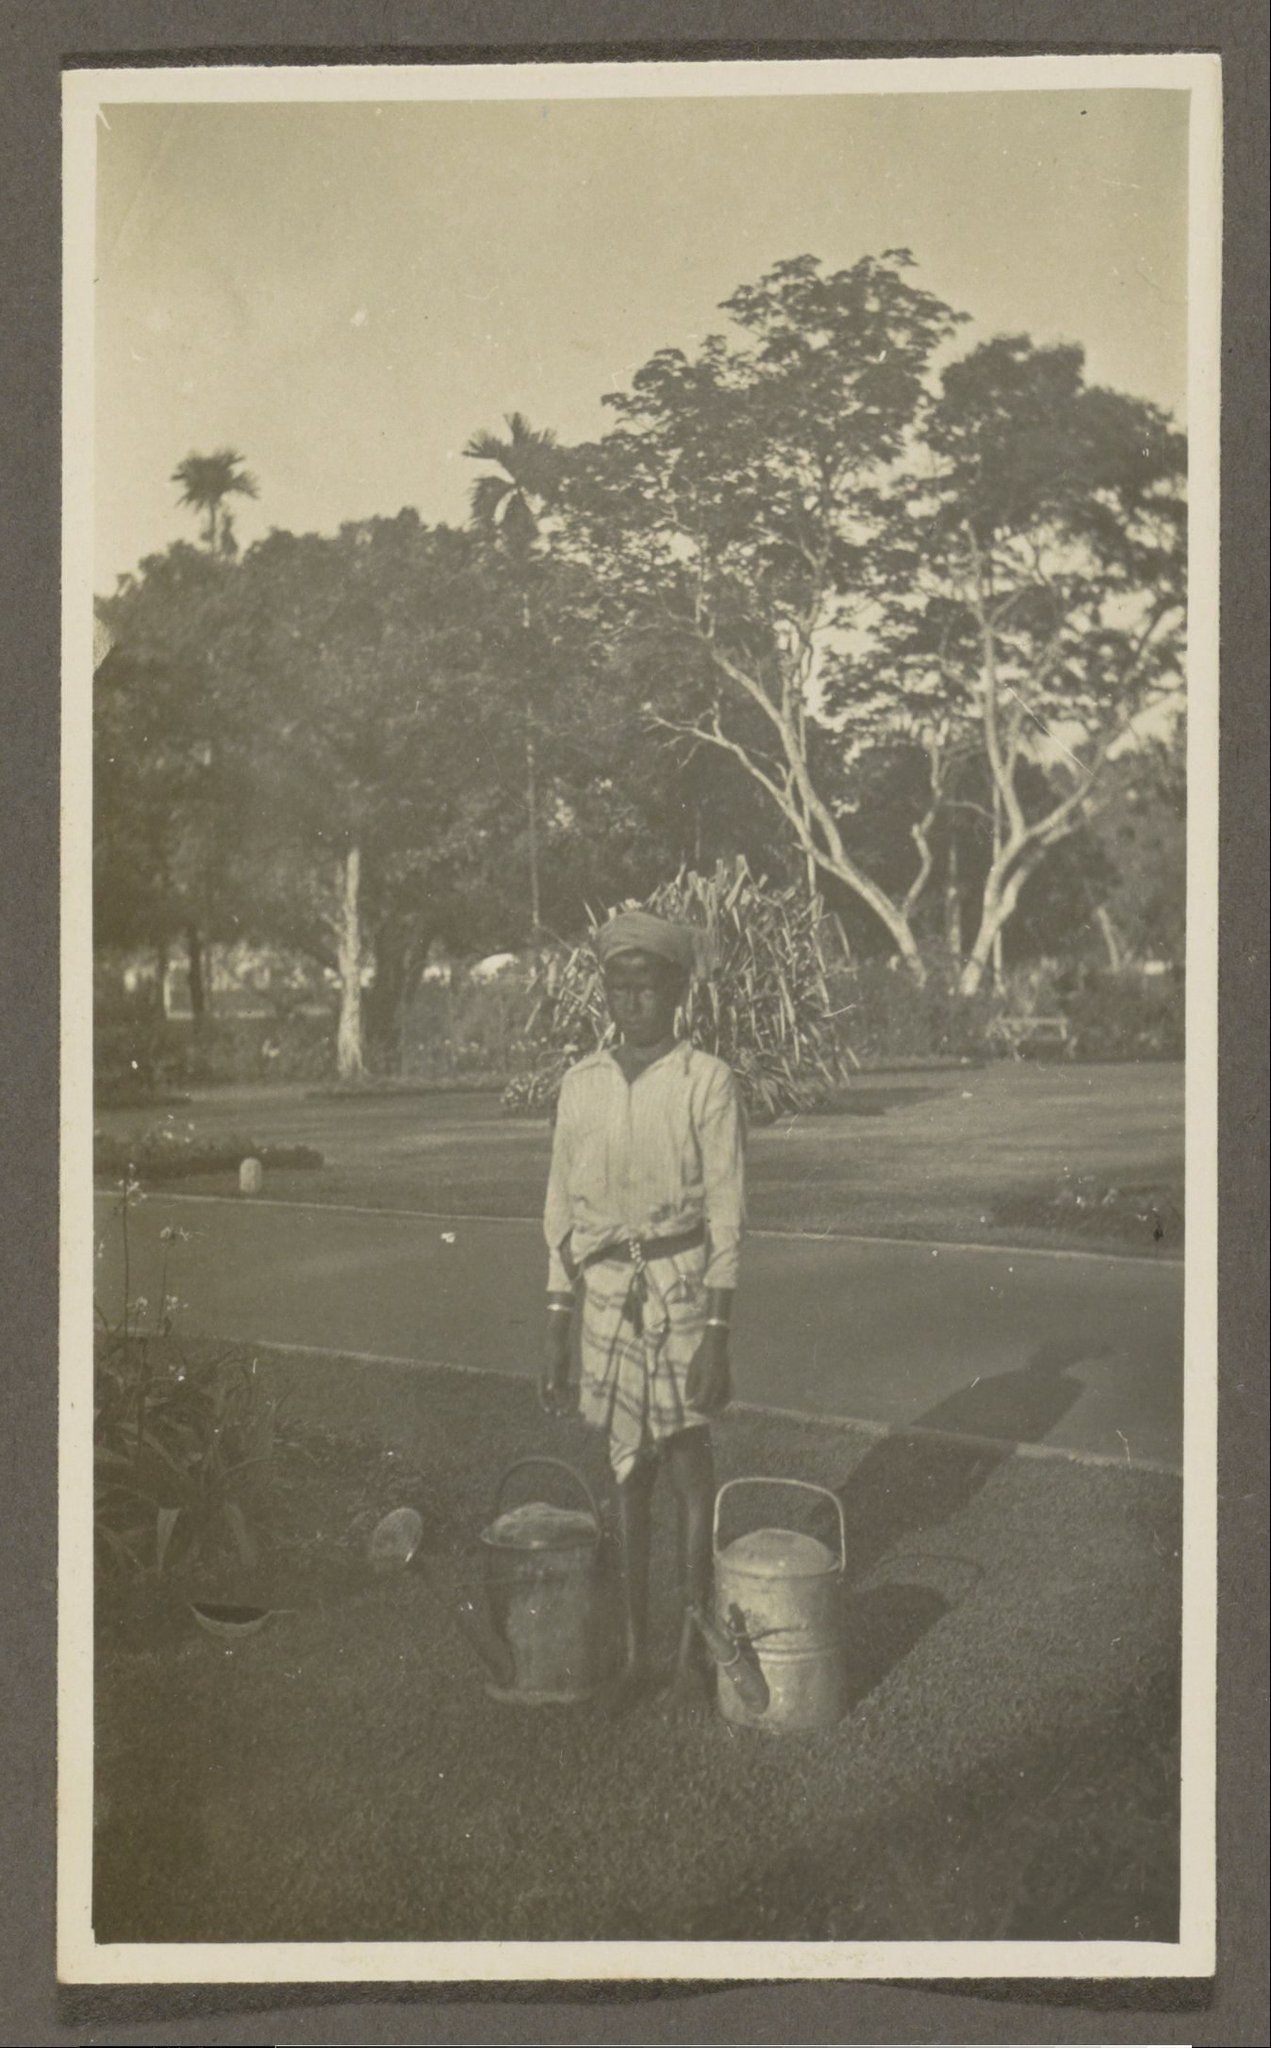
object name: photograph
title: Jongen met twee gieters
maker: Anonymous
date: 1920-1930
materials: photographic support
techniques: gelatin silver print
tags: colombo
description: Een jongen met een hemd, een lendendoek en een tulband poseert op een grasveld in de Victoria Park Gardens in de stad Colombo. Onderdeel van familiealbum Nederlands-Indië.